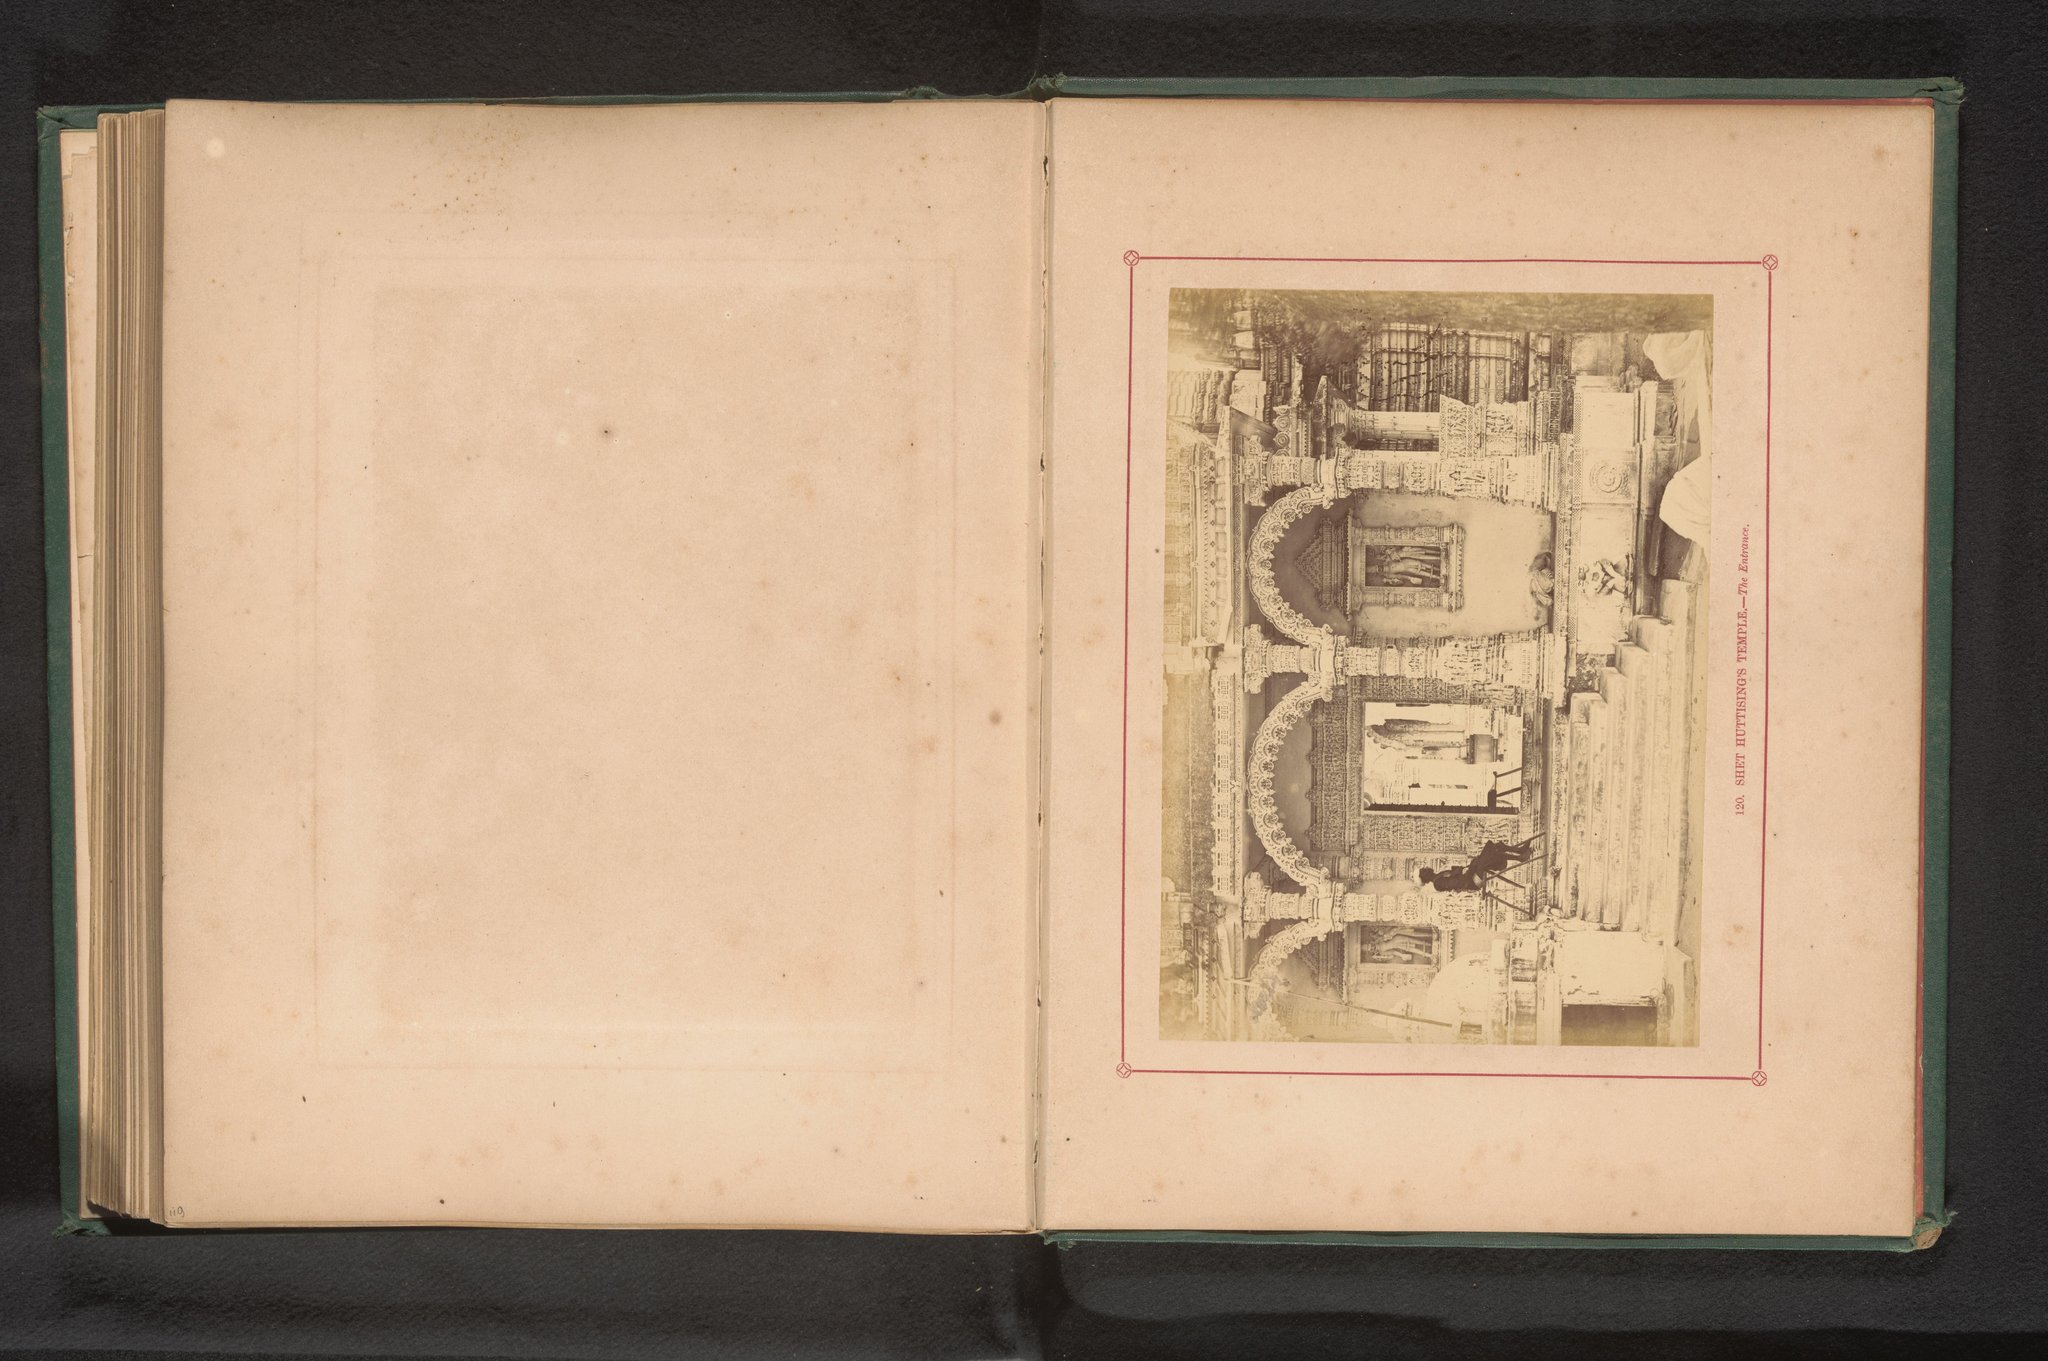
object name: page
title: Gezicht op de ingang van de Hutheesingtempel in Ahmedabad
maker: thomas biggs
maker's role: fotograaf, kapitein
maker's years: 1822-1905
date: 1856-1866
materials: photographic support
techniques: albumen print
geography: ahmedabad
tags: places and objects of worship ~ hinduism, buddhism, jainism, gate, entrance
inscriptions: number: ‘120.’